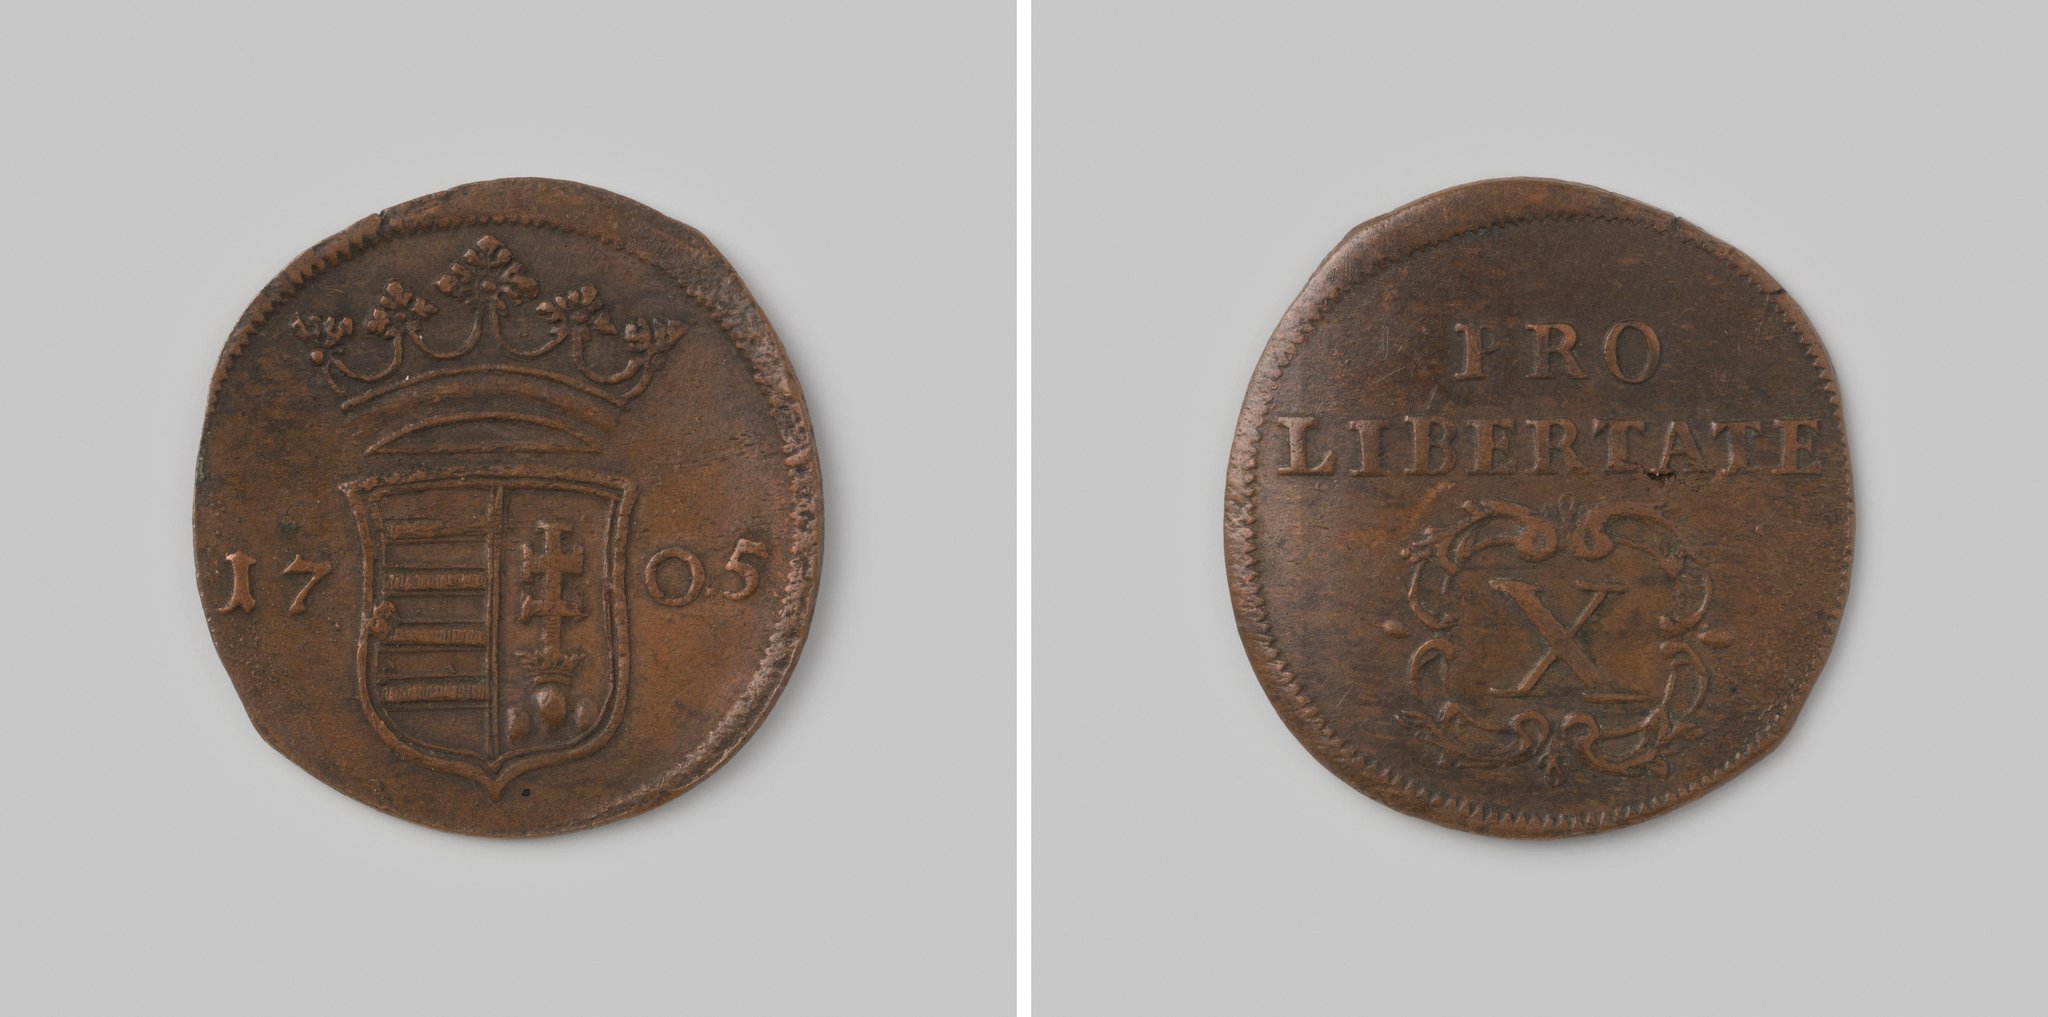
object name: tien poltura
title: Hongarije, Franz Rakoczy, 10 poltura,1705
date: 1705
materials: copper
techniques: striking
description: Koperen munt. Voorzijde: tussen jaartal gekroond wapenschild. Keerzijde: binnen versiering waarde-aanduiding: X.